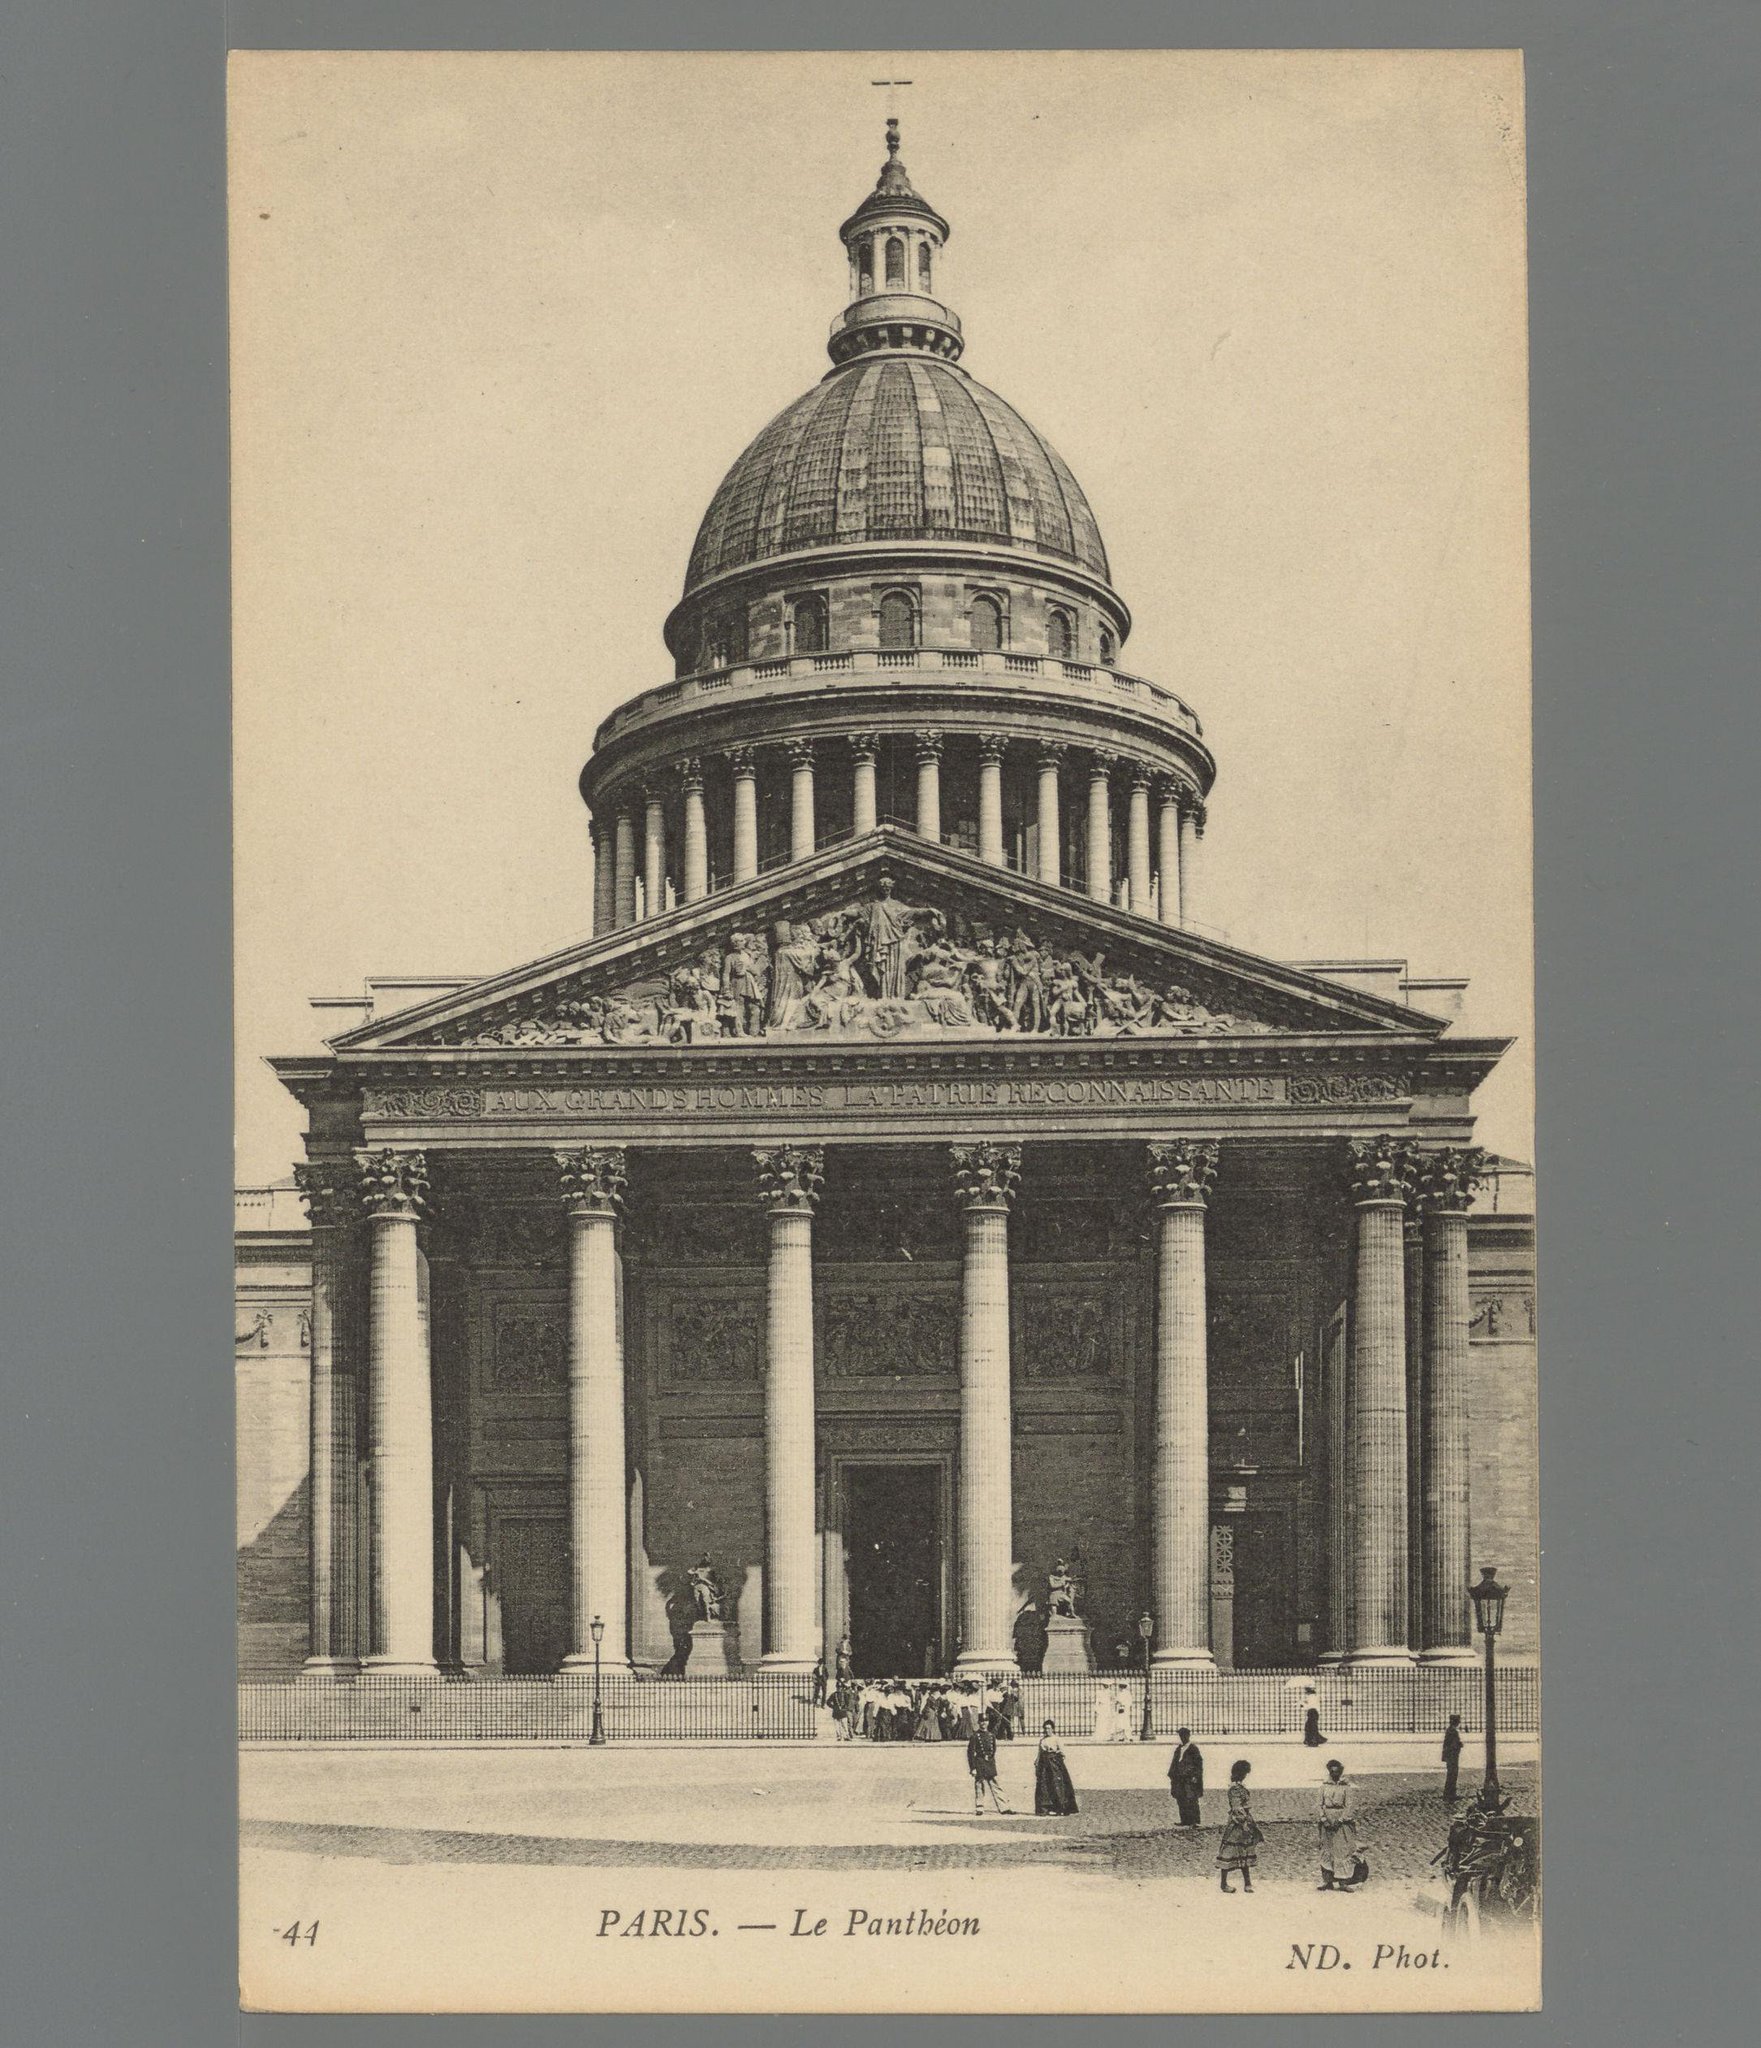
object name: photomechanical print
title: Paris. Le Panthéon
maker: Anonymous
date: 1904-1906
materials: cardboard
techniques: photograph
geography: paris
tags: exterior ~ representation of a building, dome ~ architecture, square, place, circus, etc. (+ city(-scape) with figures, staffage)